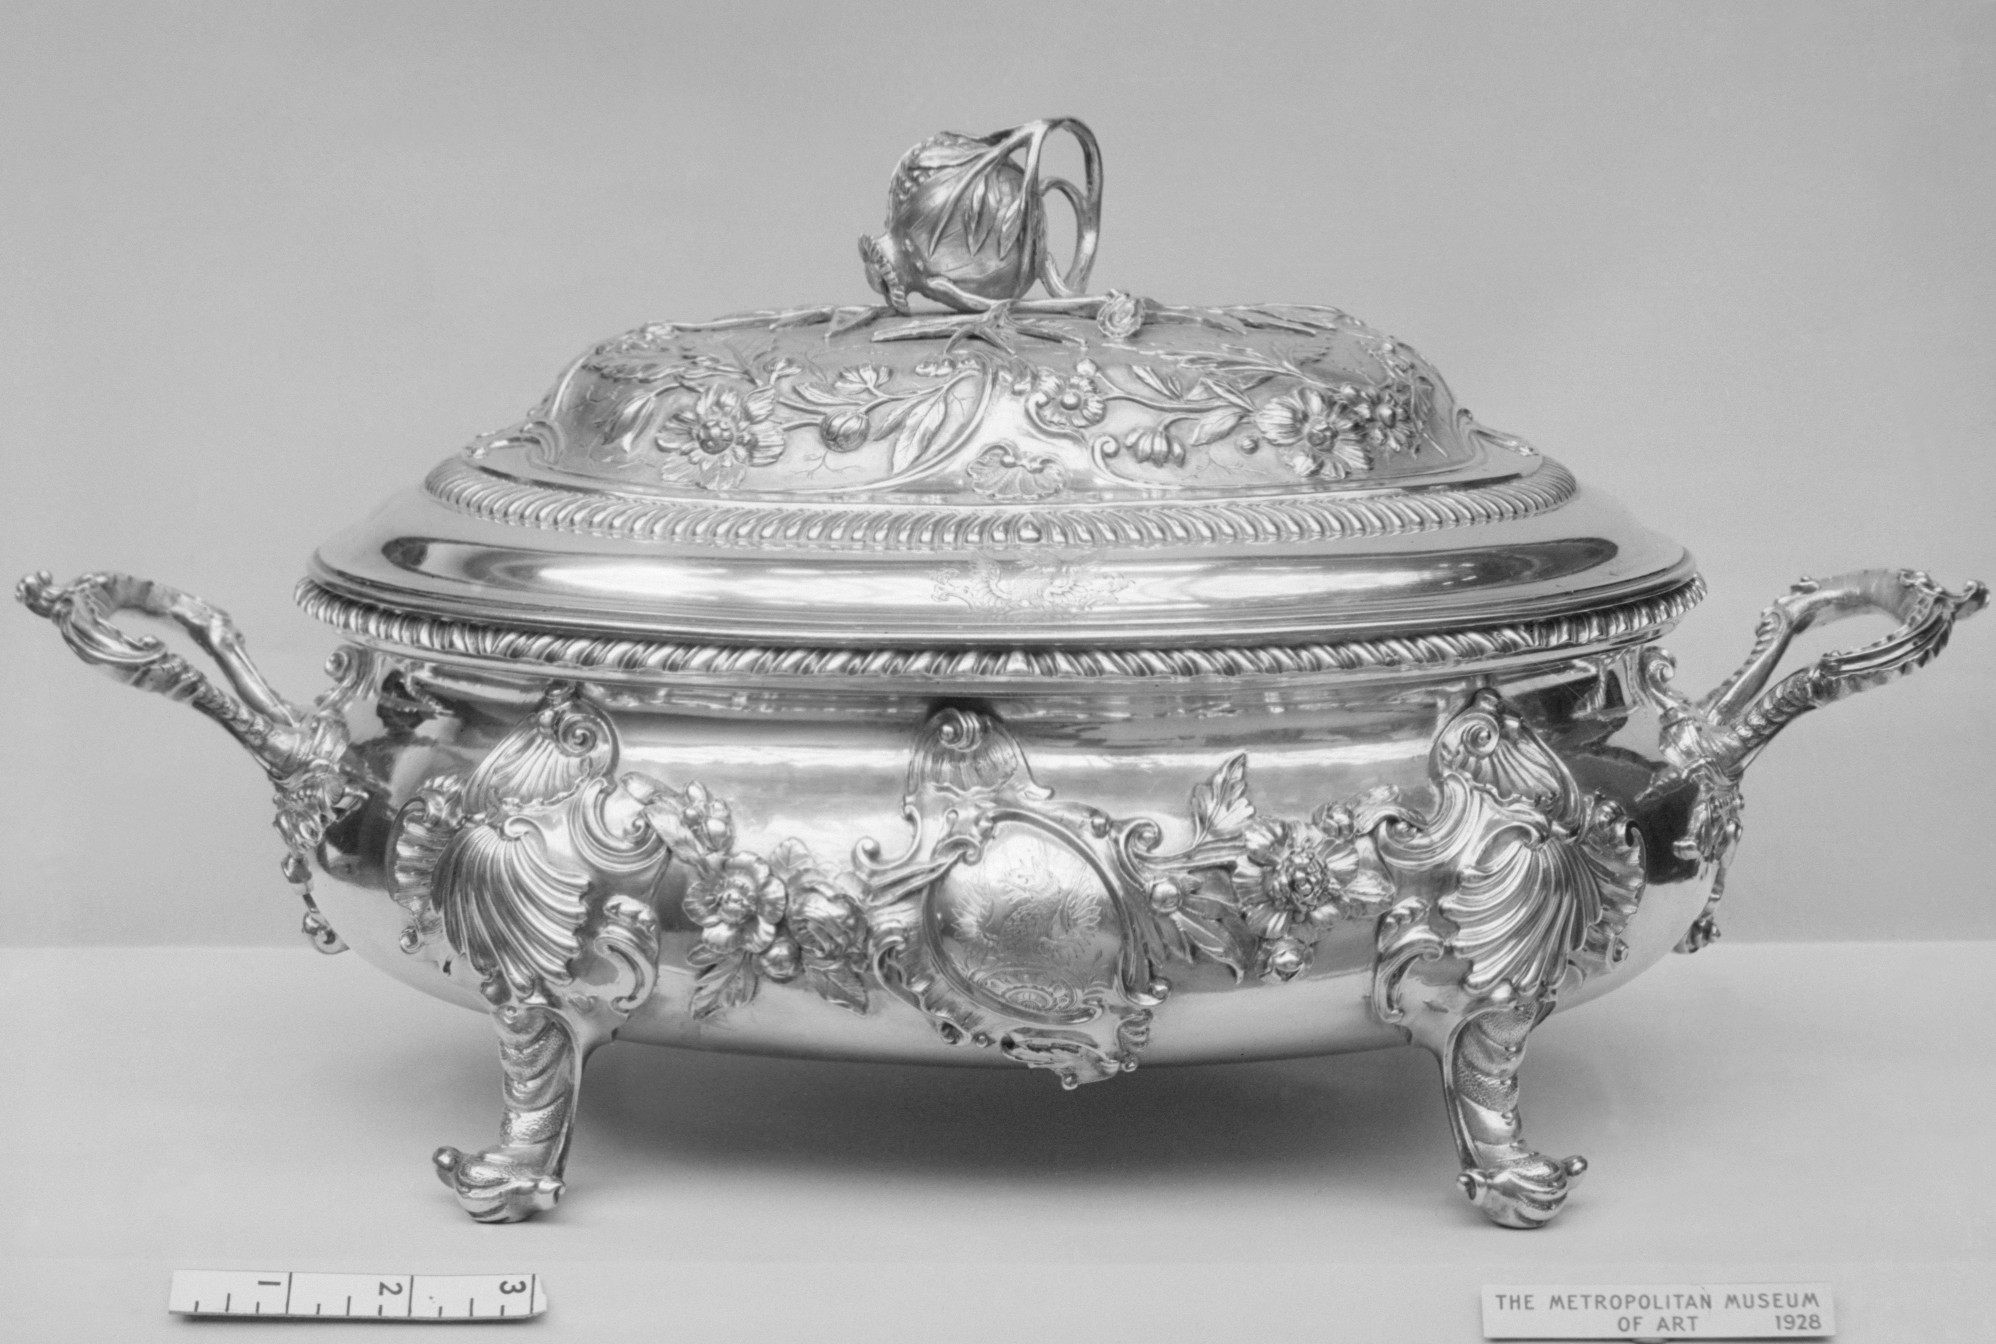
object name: soup tureen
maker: john swift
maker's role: maker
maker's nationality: british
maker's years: 1728-1828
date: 1758-1759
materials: silver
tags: flowers